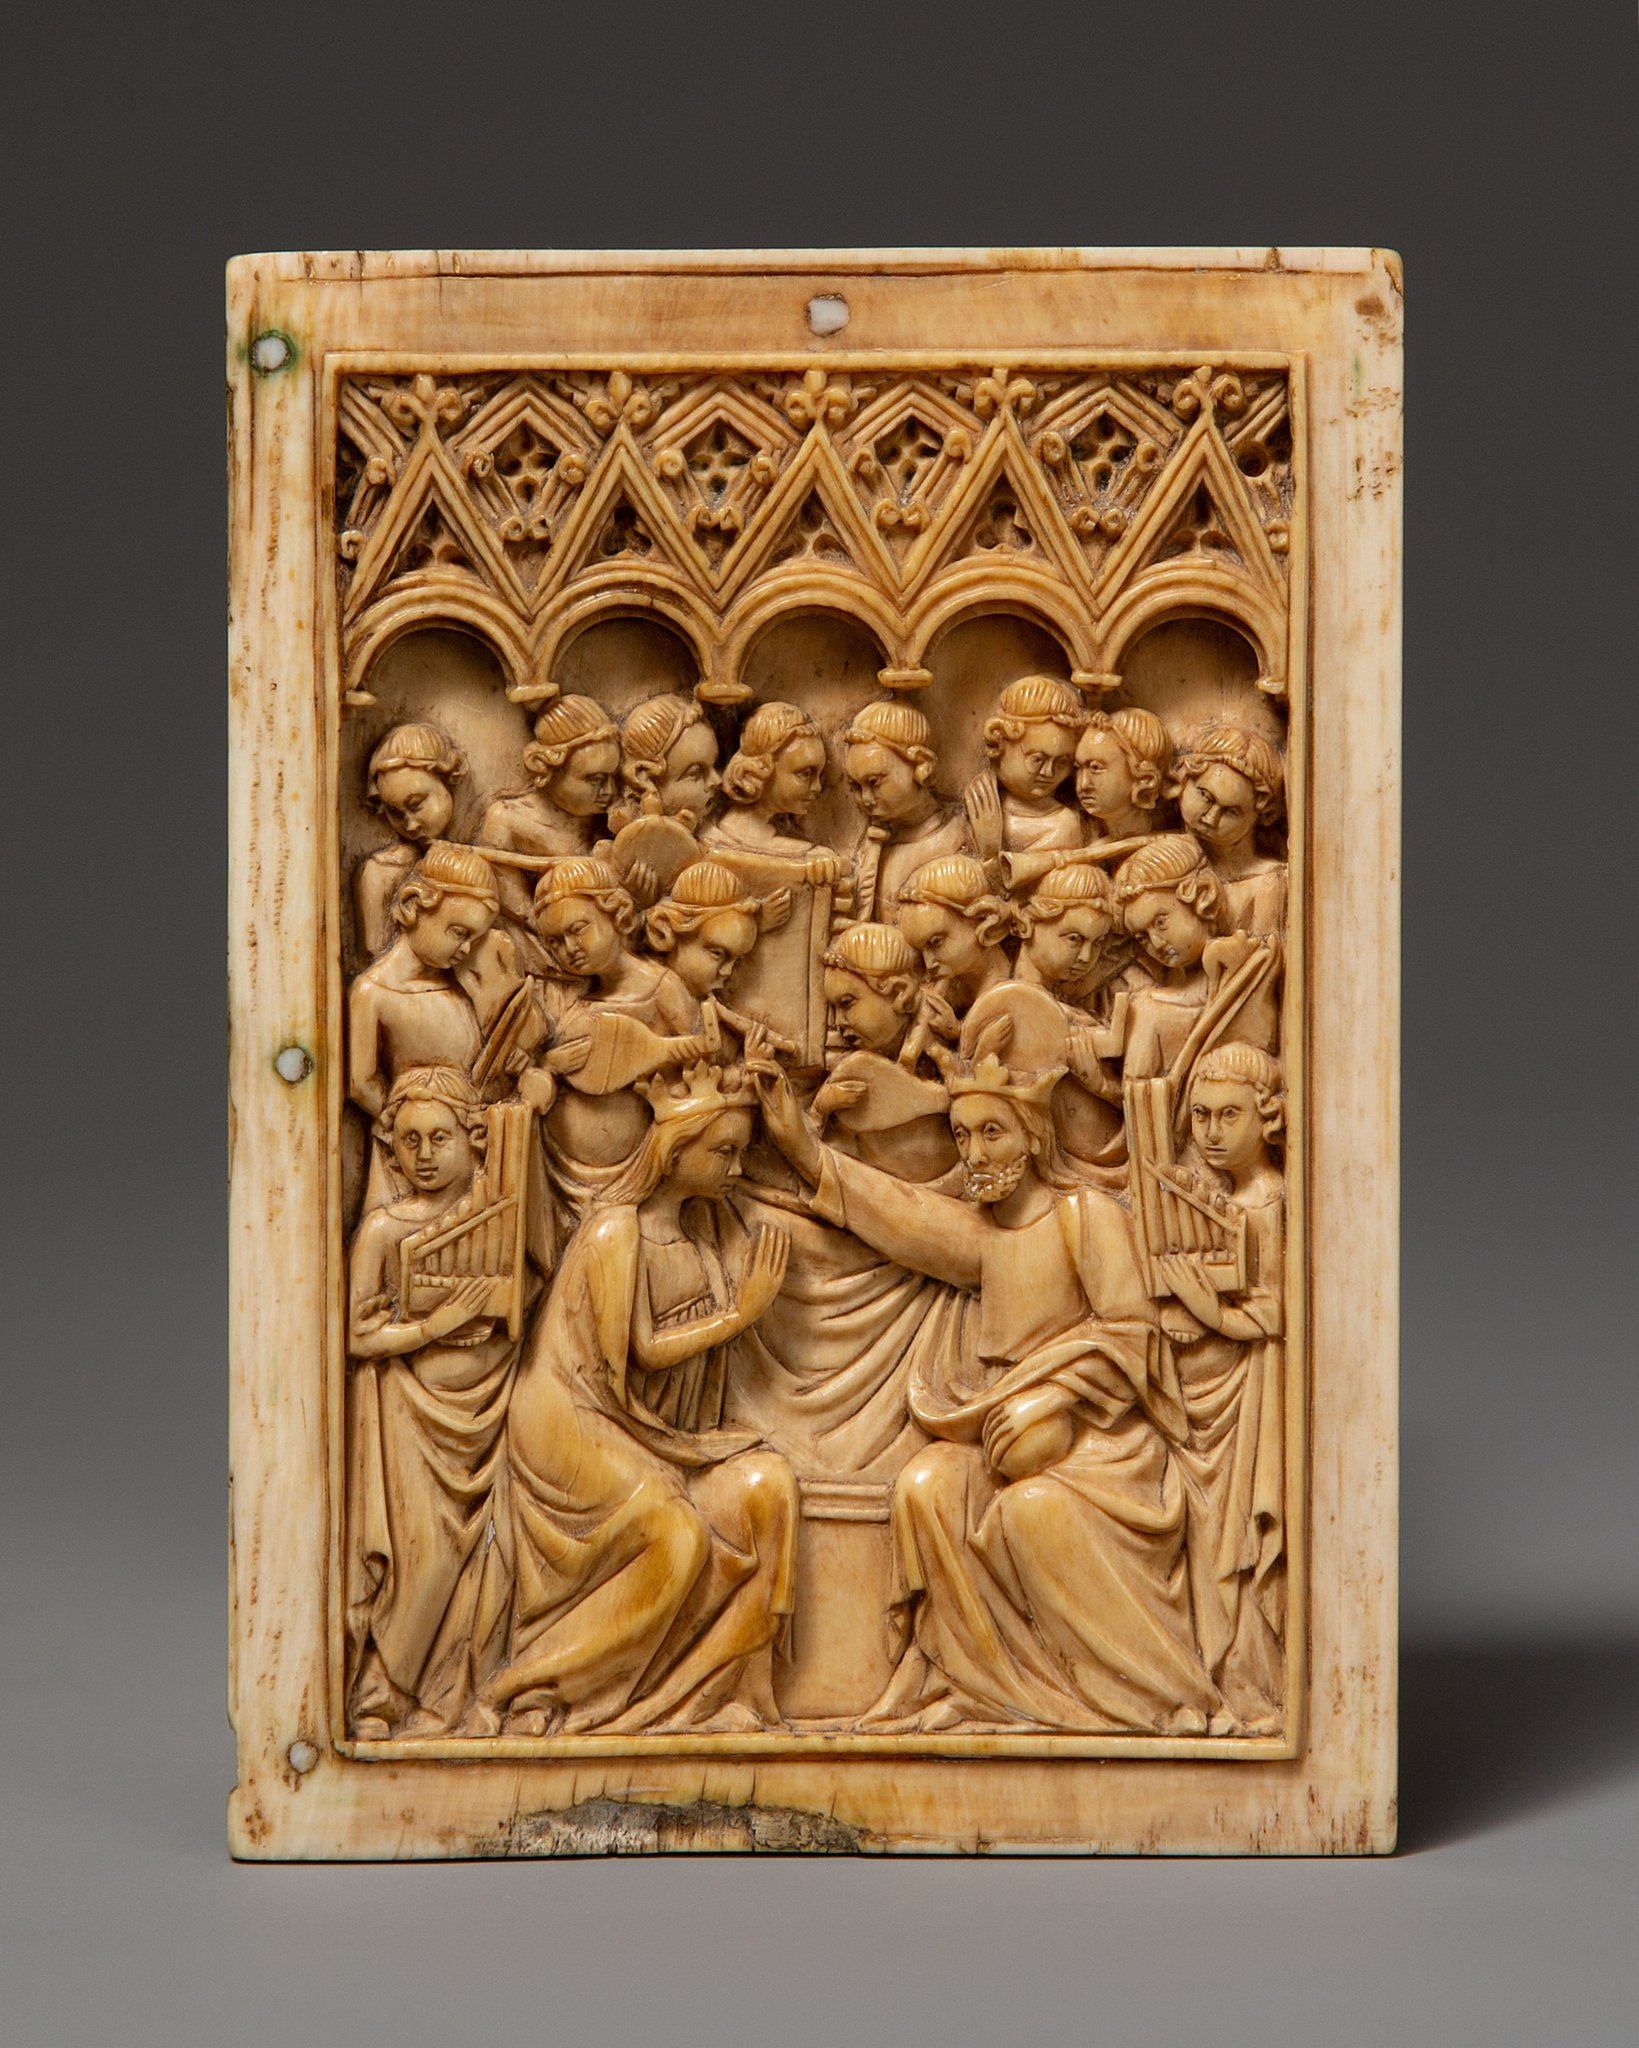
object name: diptych leaf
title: Right Leaf of a Diptych with Coronation of the Virgin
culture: italian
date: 1367-1400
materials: ivory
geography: italy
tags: musical instruments,angels,christ,virgin mary